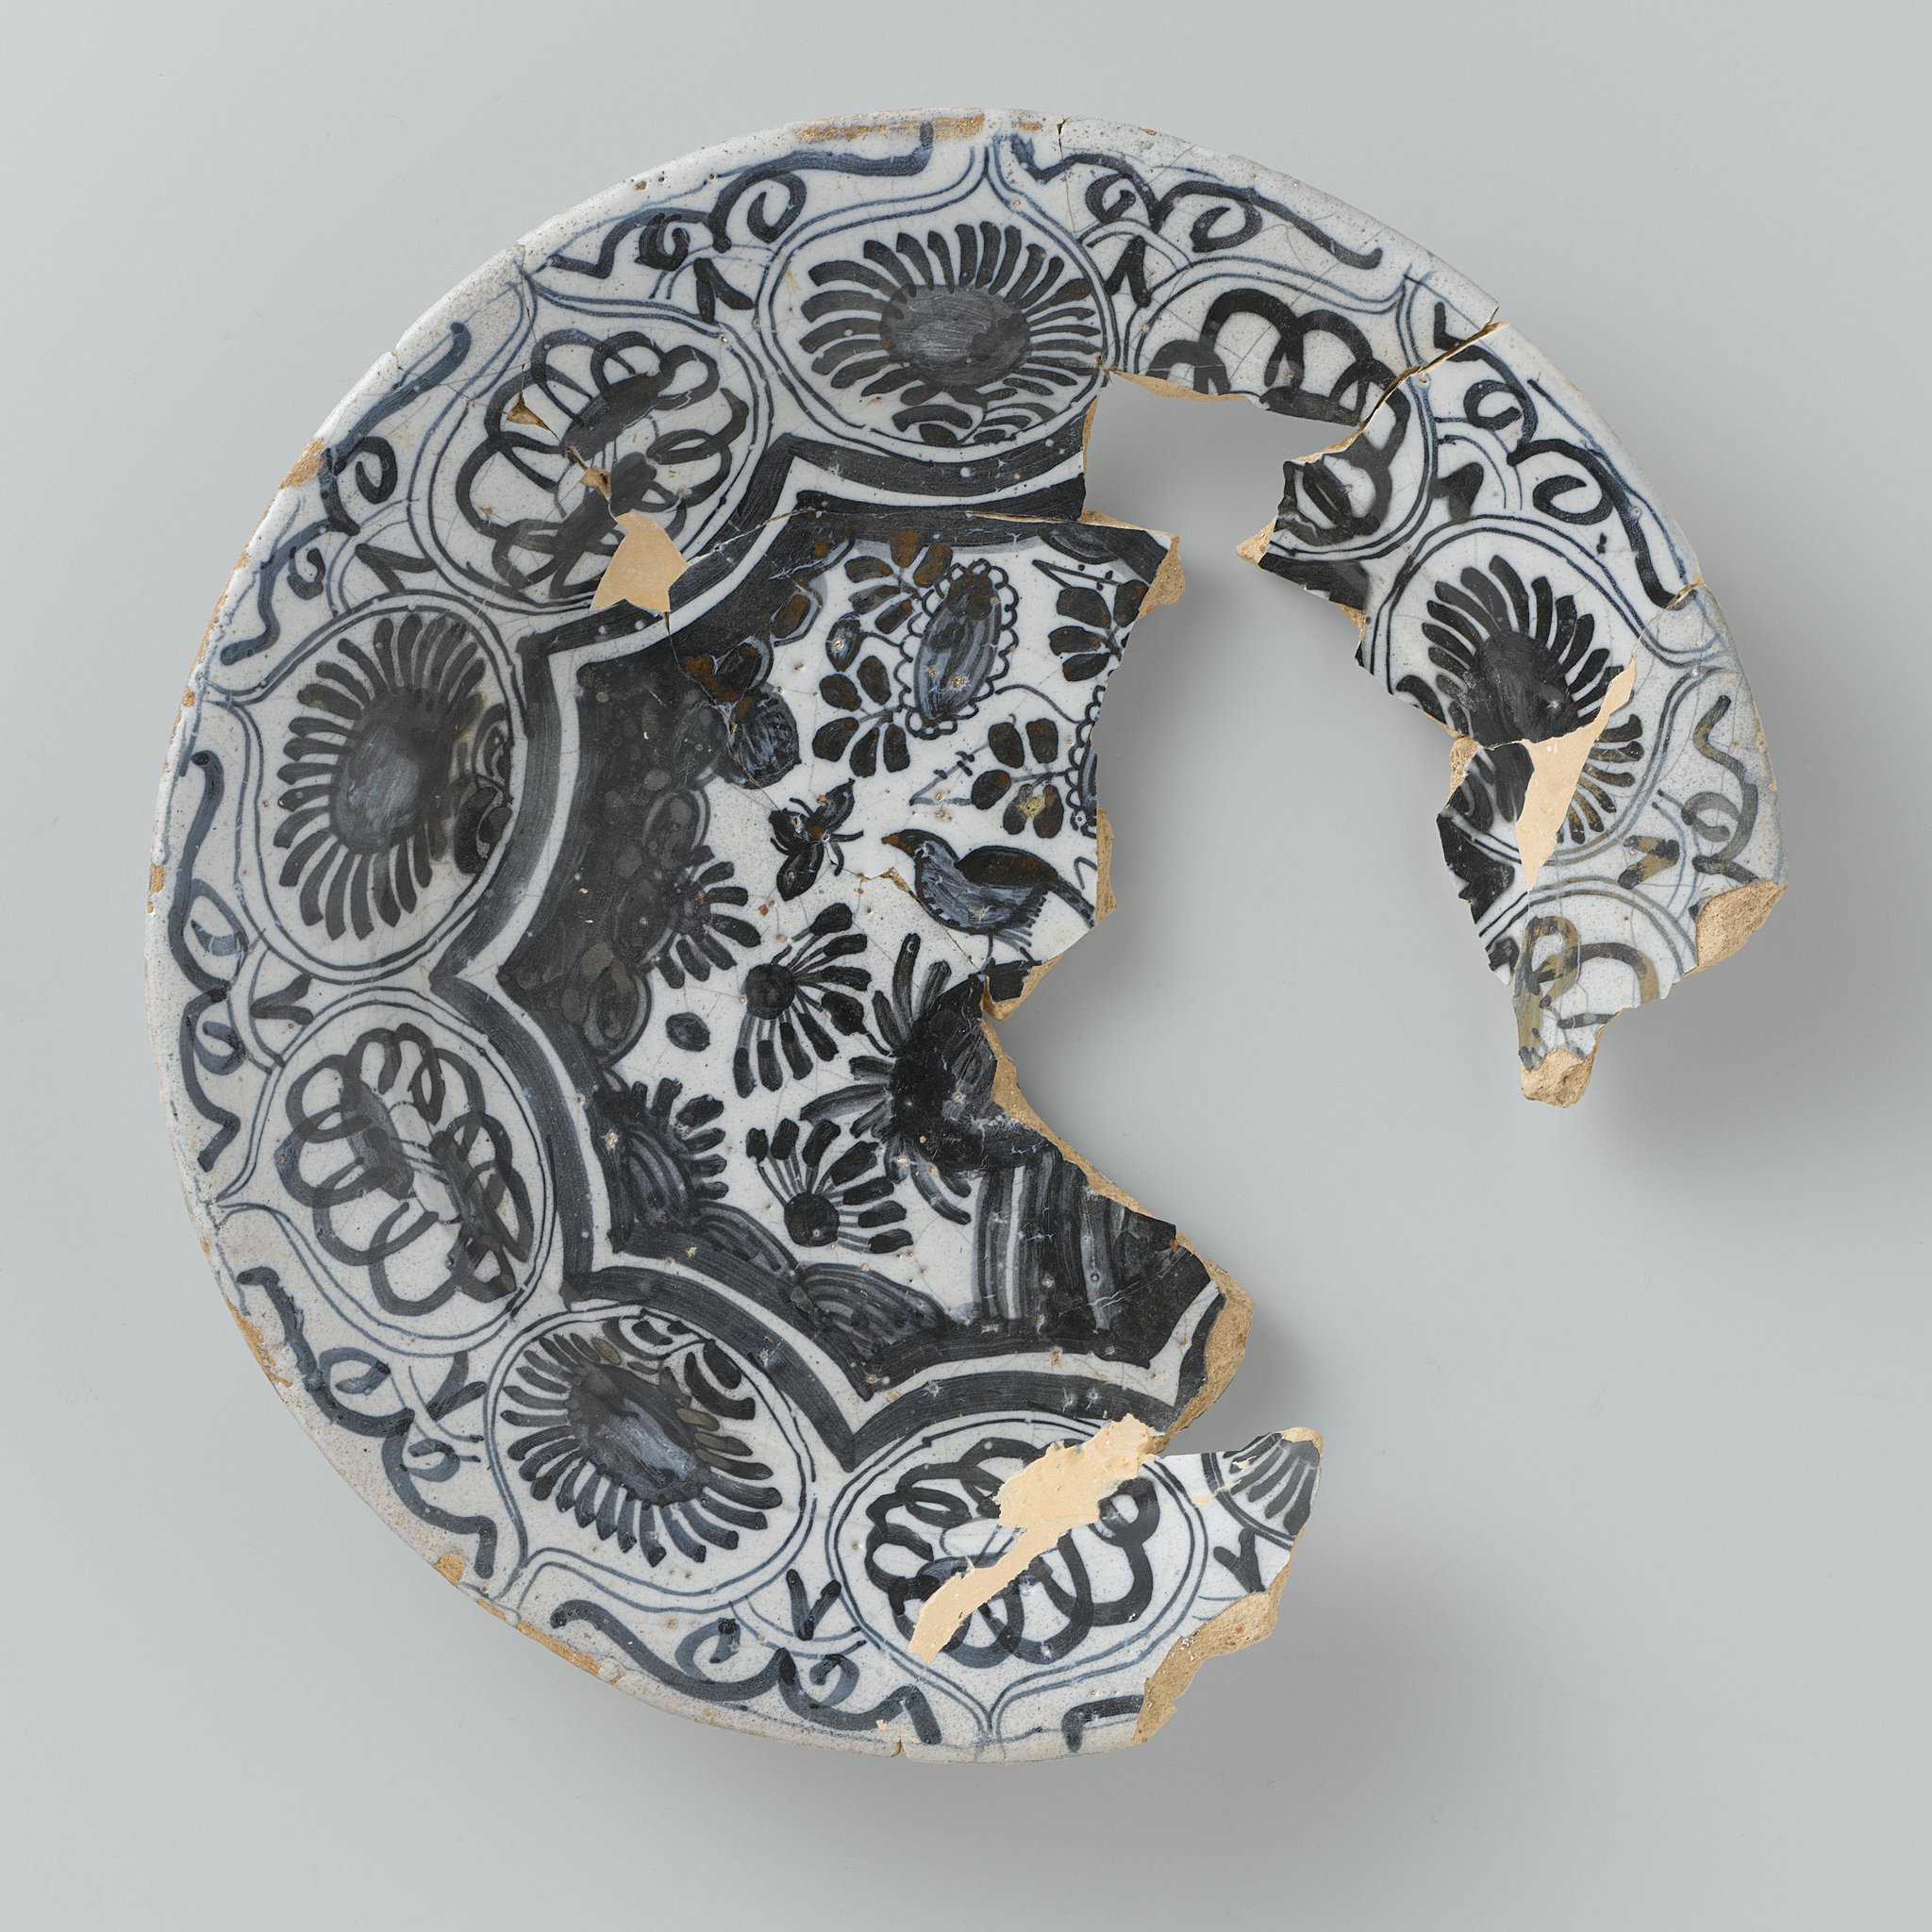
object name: fragment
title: Bord, fragment, met op het plat een vogel in blauw. Rand met Wan Li decor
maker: Anonymous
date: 1650-1690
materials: earthenware, glaze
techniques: painted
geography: delft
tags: delft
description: Rond bord (fragmentarisch) van blauw beschilderde faience, met een Wan-Li rand en een vogel op het plat. Het bord is een bodemvondst uit Delft.